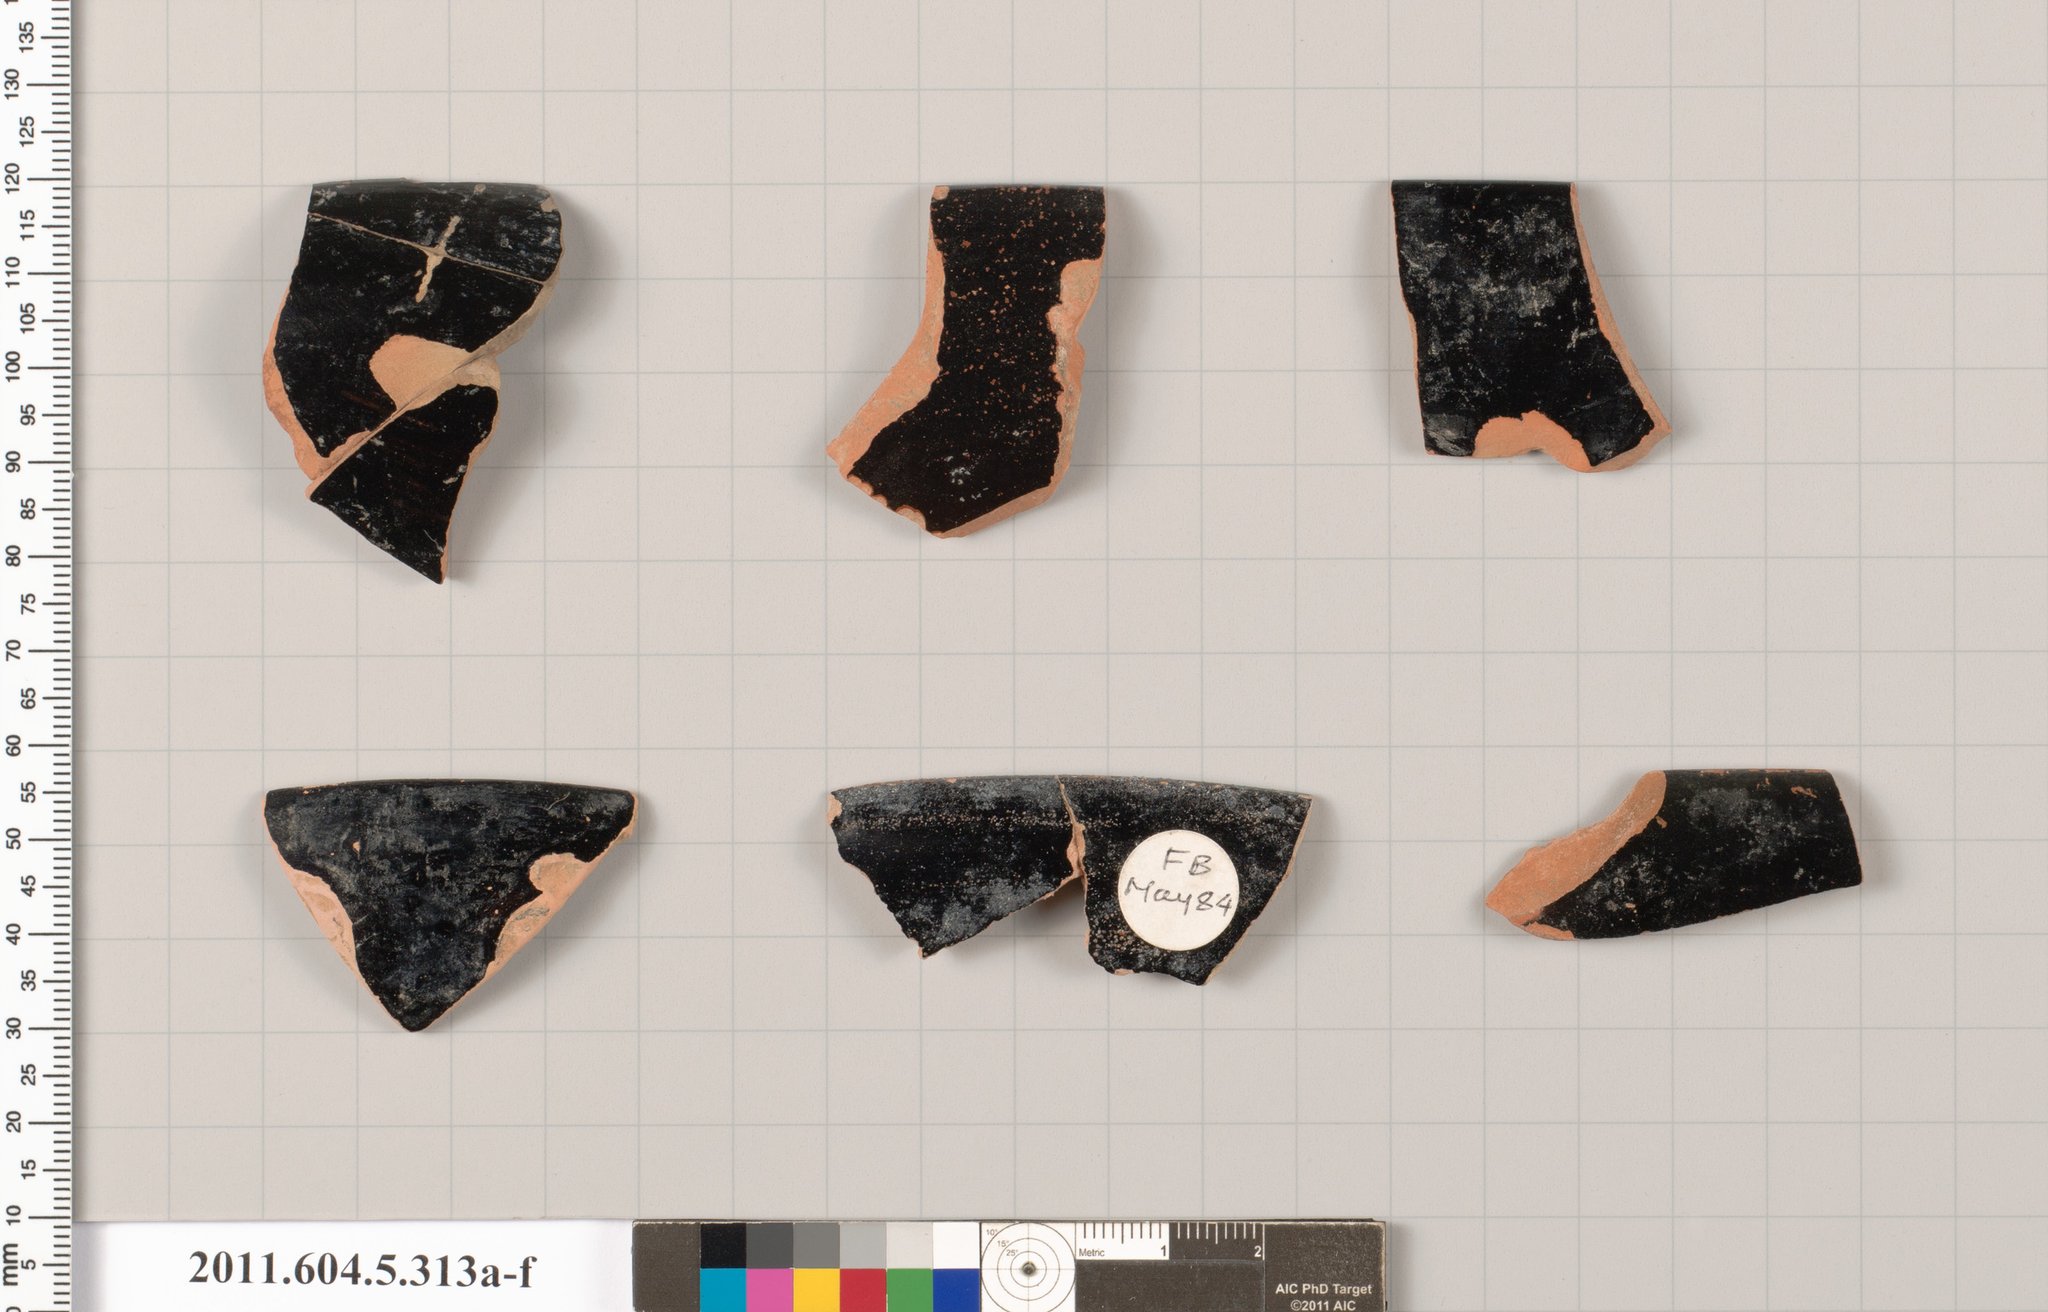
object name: kylix fragment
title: Terracotta rim fragments of kylikes (drinking cups)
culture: greek, attic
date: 600-401 BCE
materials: terracotta